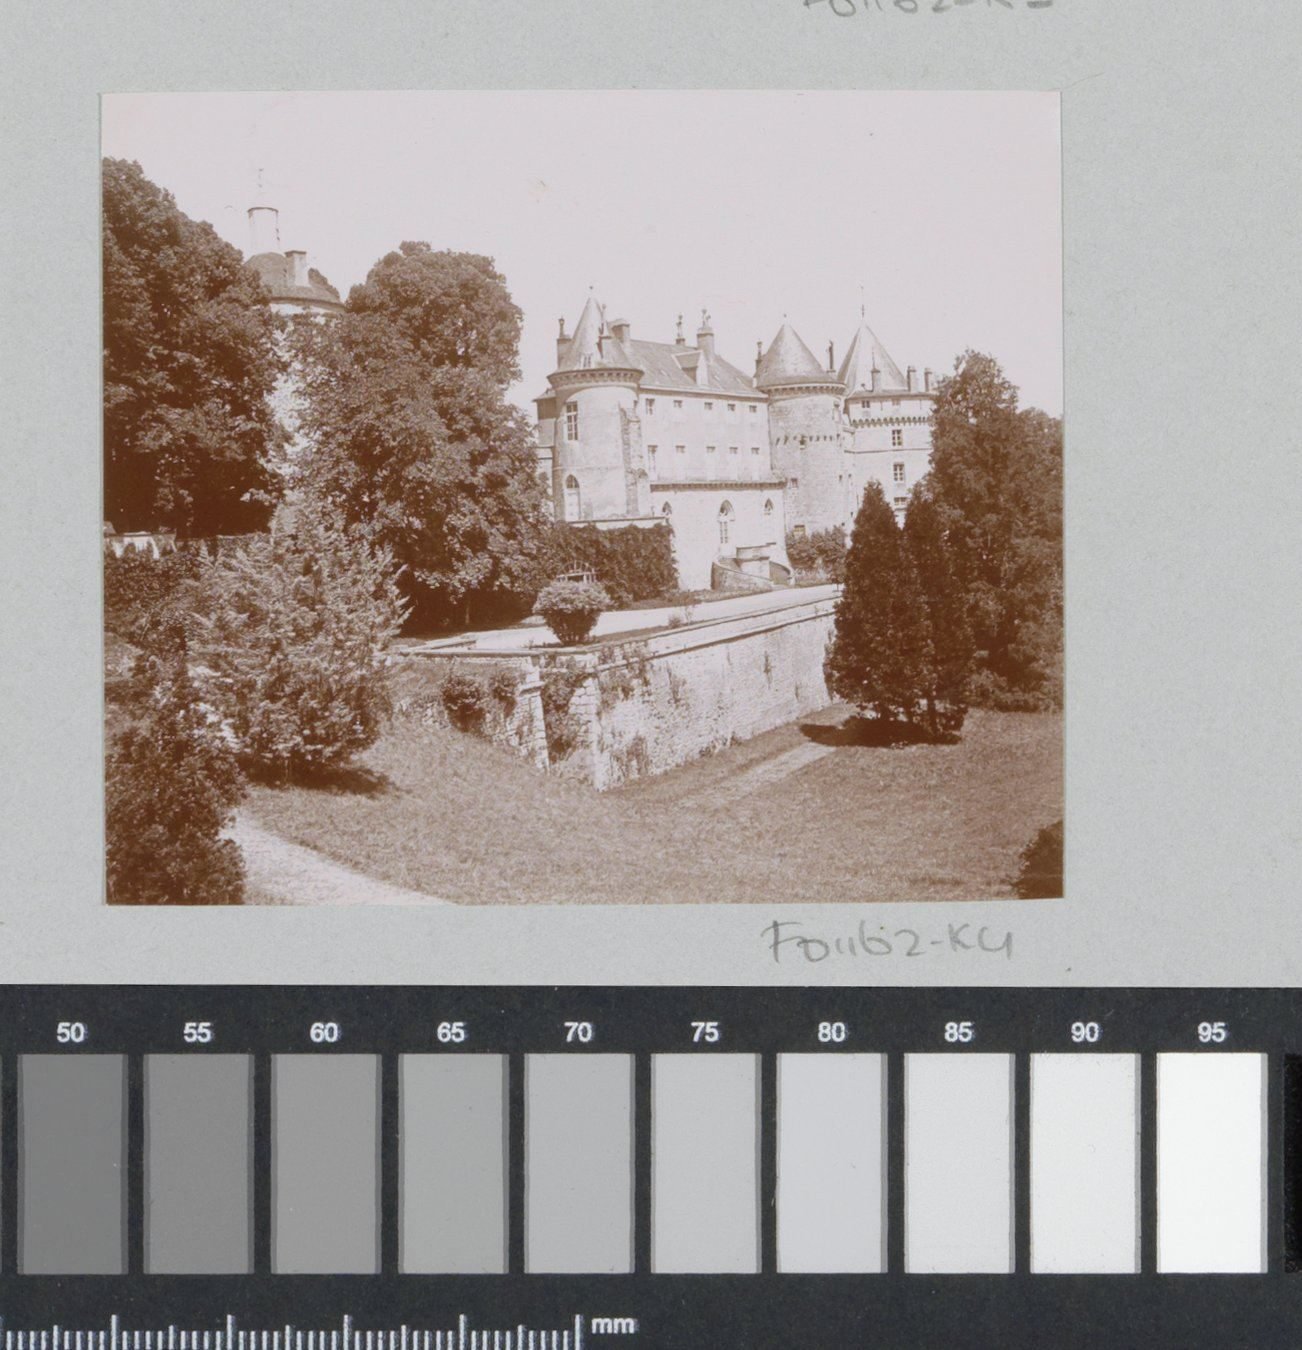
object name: photograph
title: Gezicht op een kasteel met een terras en een tuin, vermoedelijk in Frankrijk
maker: Anonymous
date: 1905-1910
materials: paper, photographic support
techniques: gelatin silver print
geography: france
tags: castle, garden, terrace, france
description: Onderdeel van Fotoalbum van een Franse amateurfotograaf met bezienswaardigheden in Frankrijk, Zwitserland en Italië.